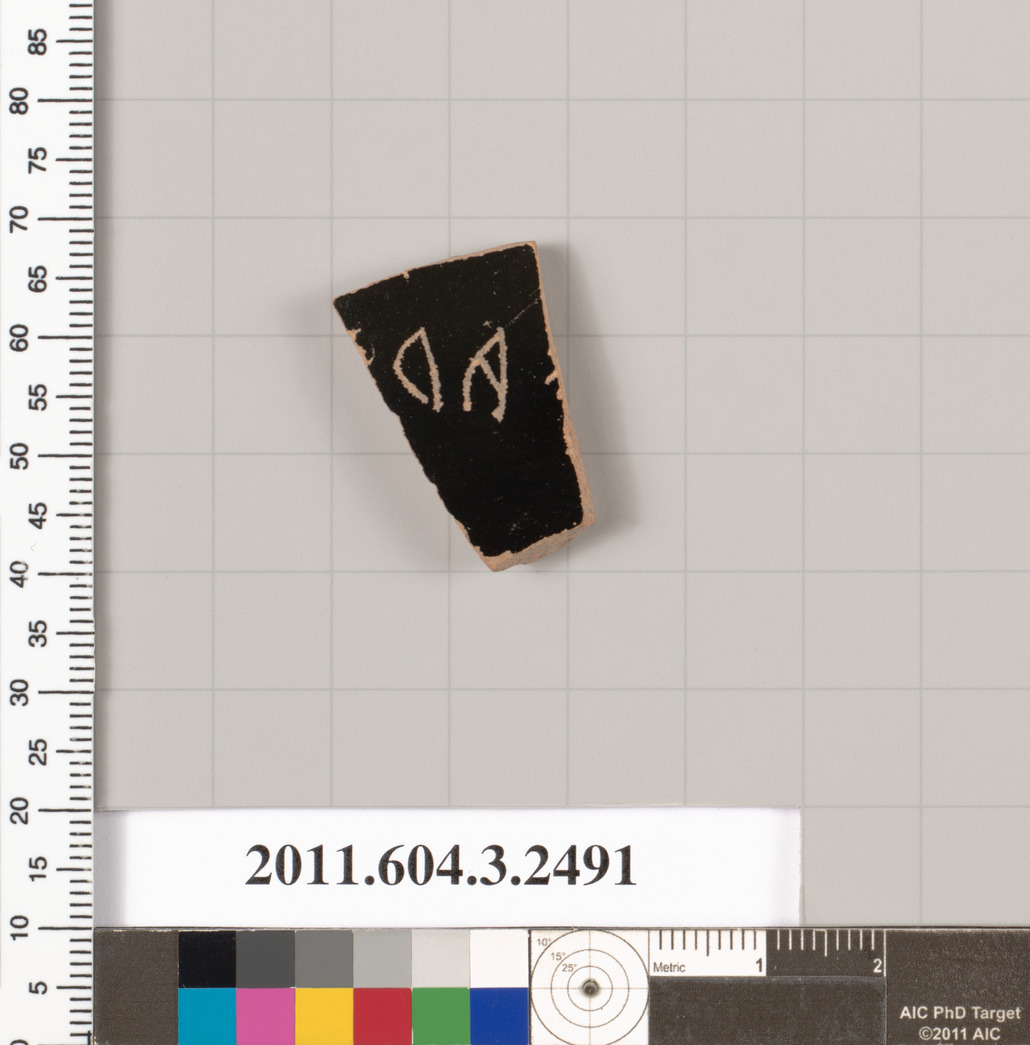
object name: kylix fragment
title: Terracotta fragment of a kylix (drinking cup)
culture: greek, attic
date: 600-401 BCE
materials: terracotta